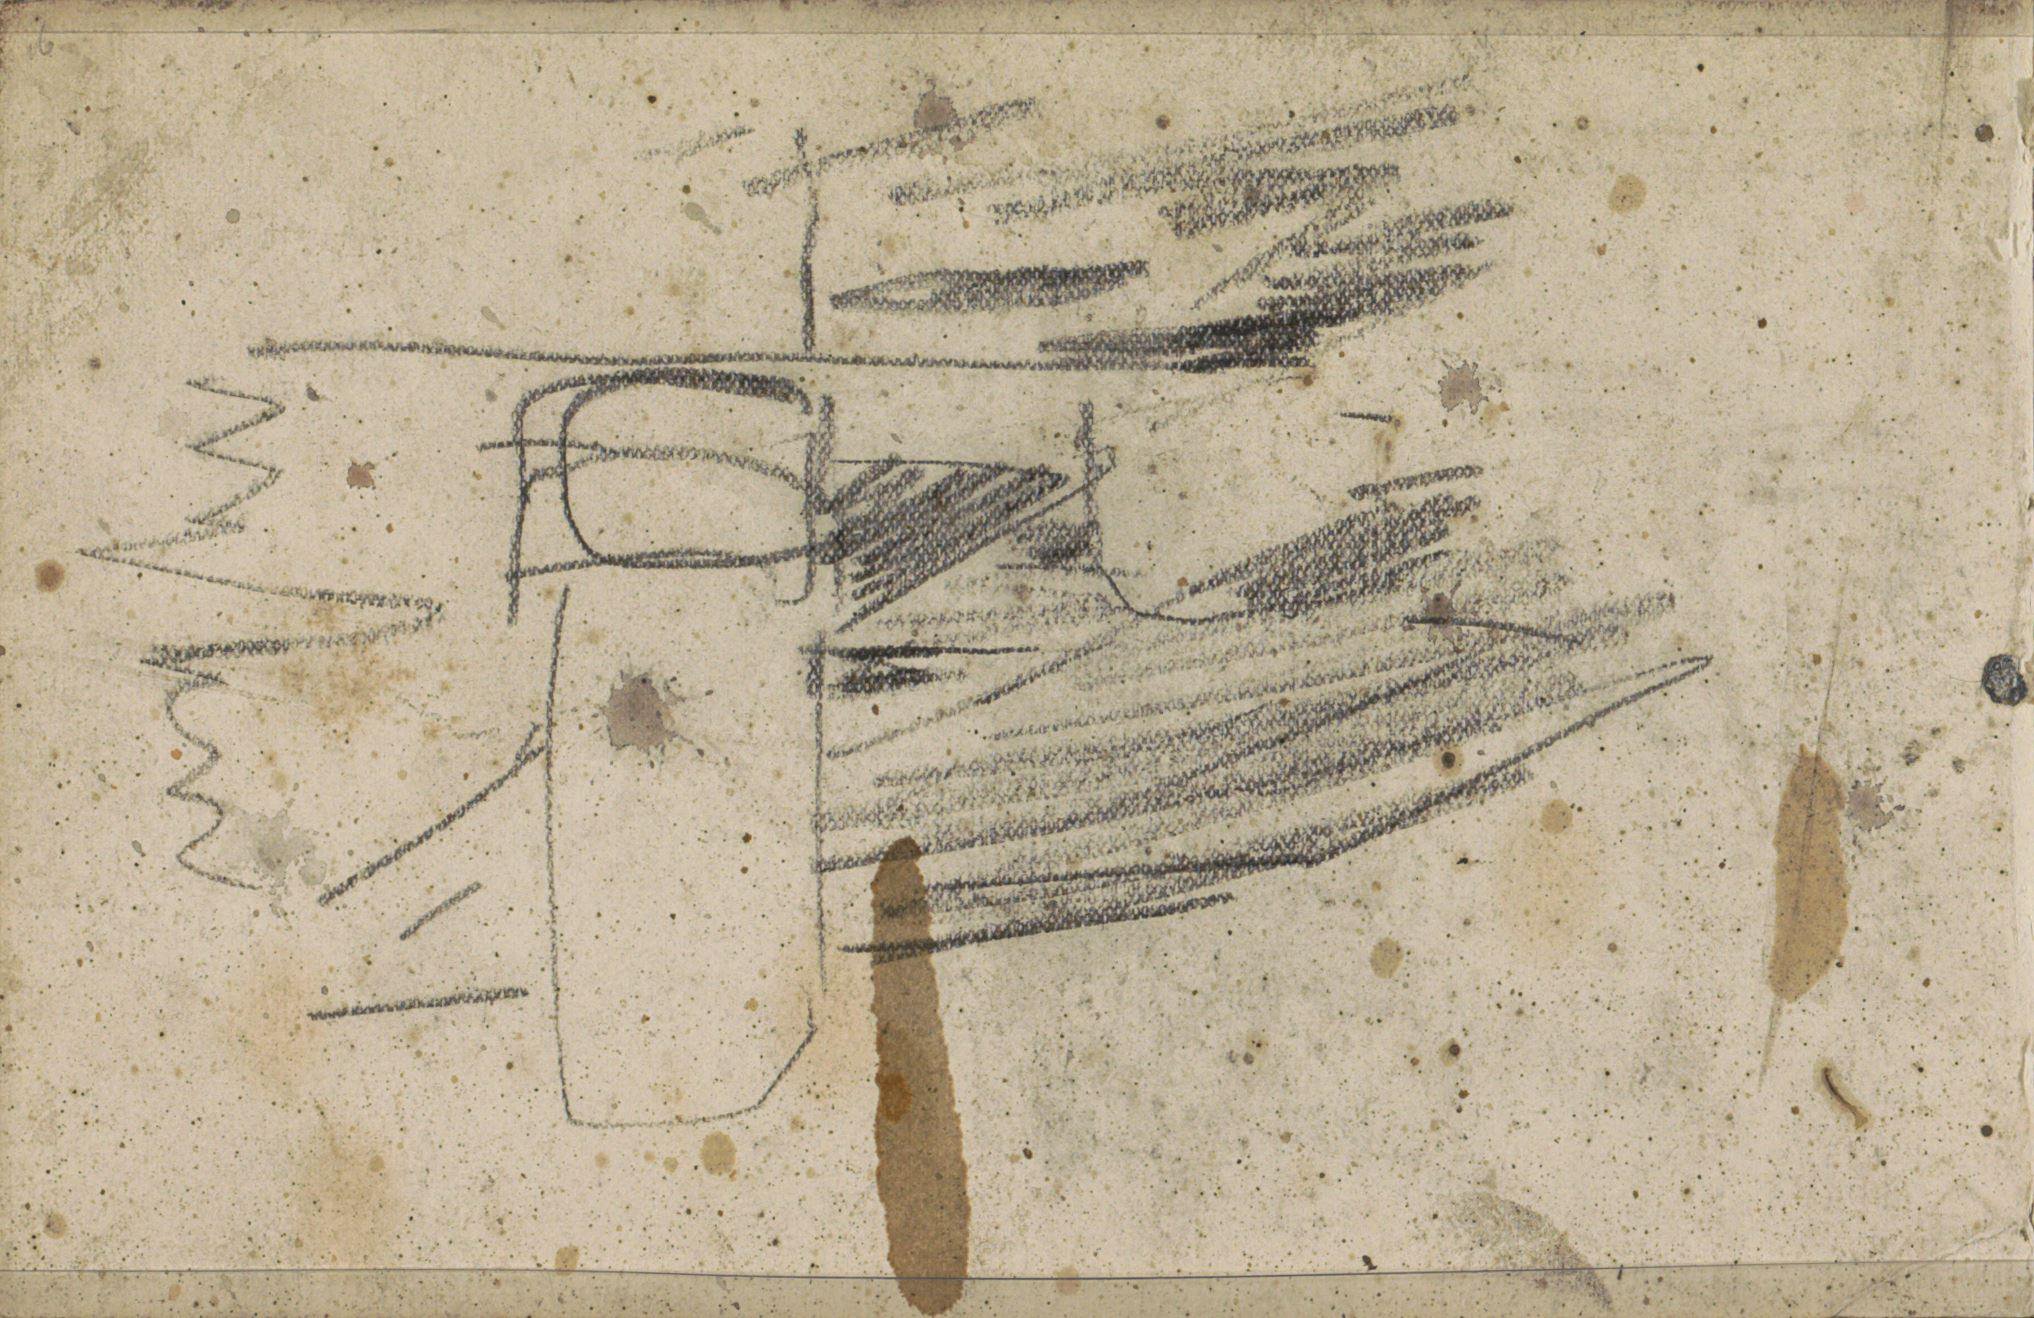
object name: sketchbook leaf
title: Studie, mogelijk van bebouwing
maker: willem witsen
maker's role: draughtsman, painter, print maker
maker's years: 1860-1923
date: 1888-1891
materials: chalk, paper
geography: london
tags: civic architecture; edifices; dwellings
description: Pagina 16 uit een schetsboek met 19 bladen.